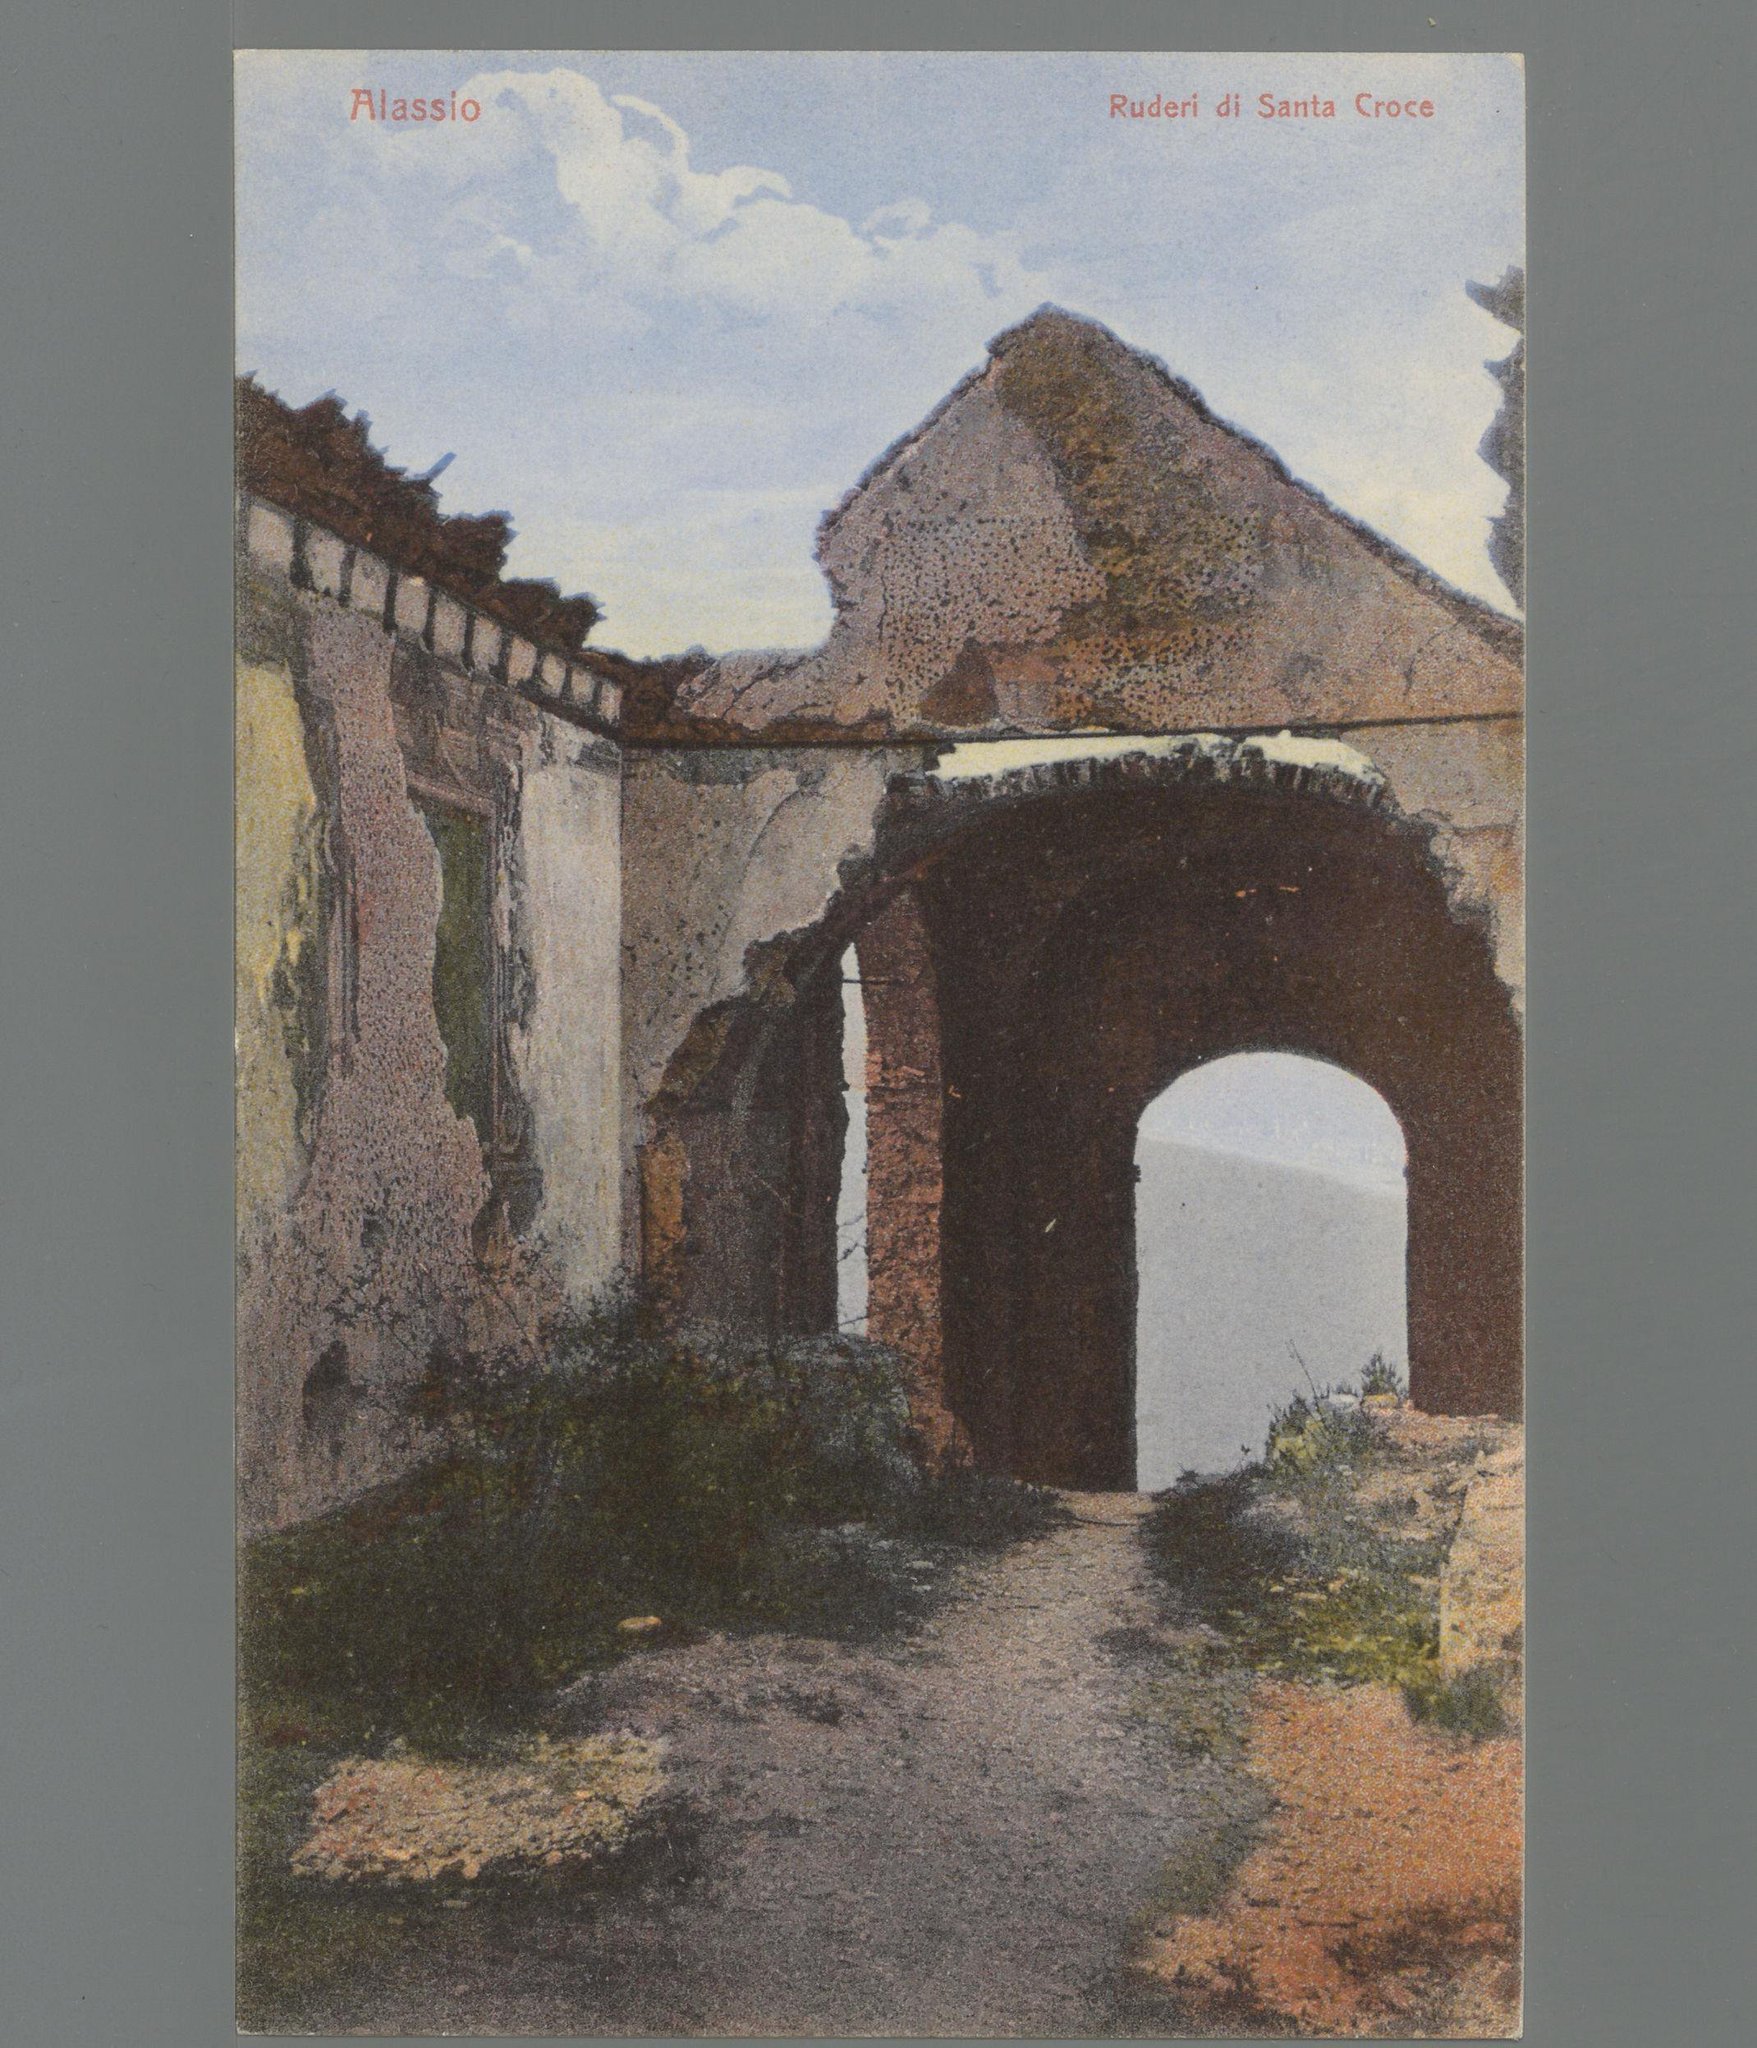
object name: photomechanical print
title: Alassio. Ruderi di Santa Croce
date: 1905-1909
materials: cardboard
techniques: photograph, lithograph, writing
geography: alassio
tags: landscape with ruins, ruin of church, monastery, etc.